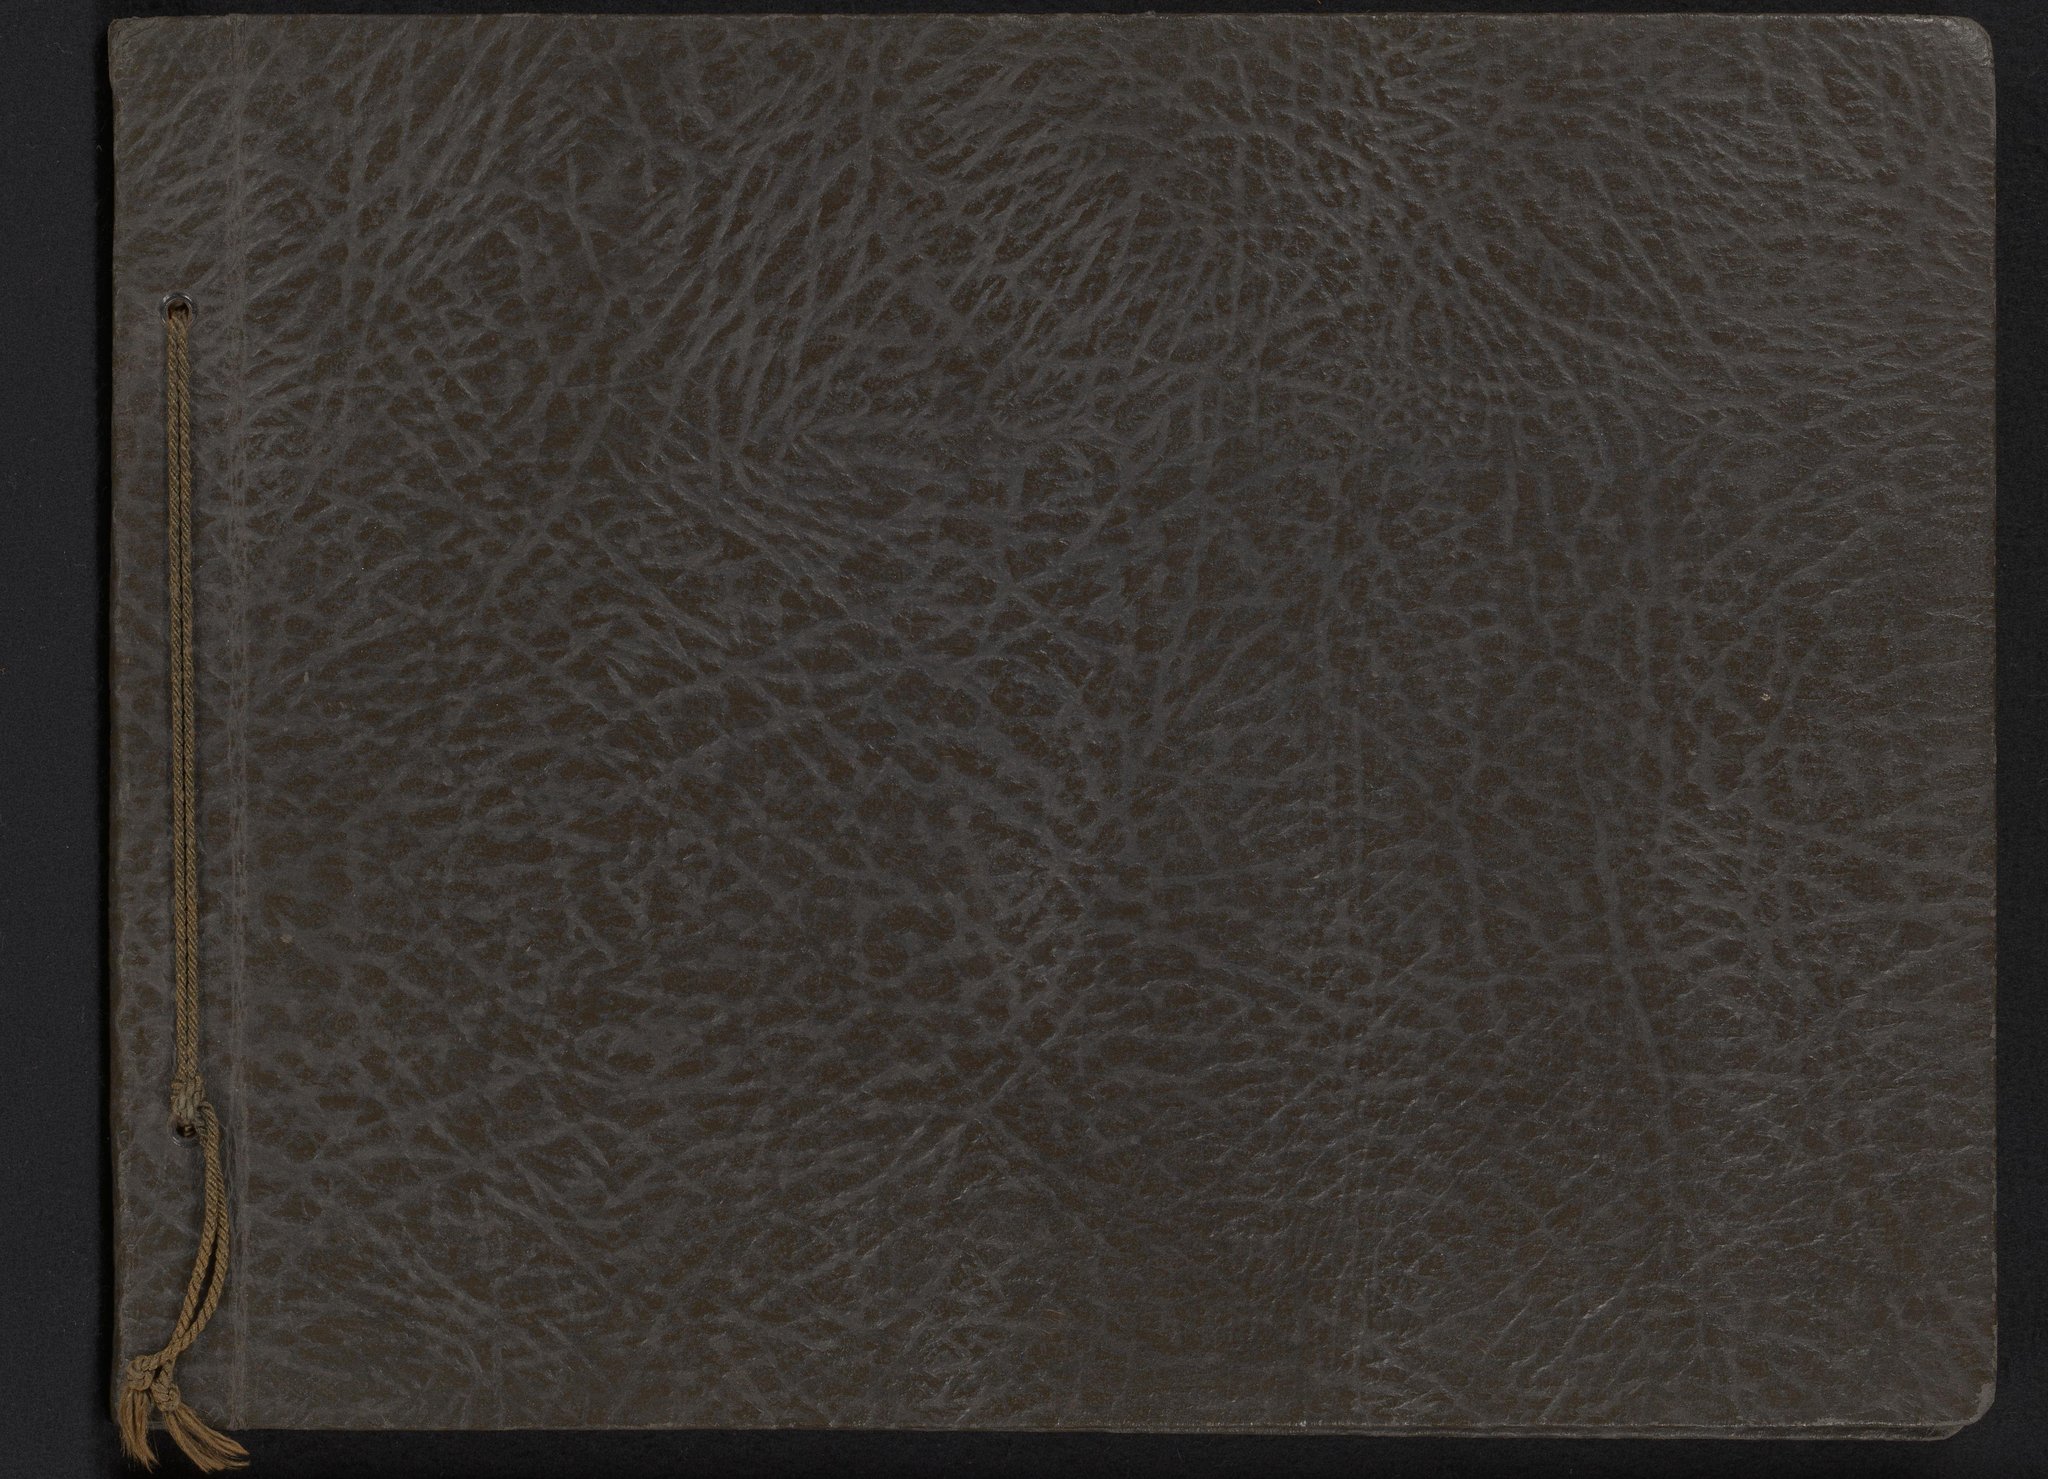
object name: photograph album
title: Fotoalbum met kunstnijverheidsvoorwerpen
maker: Anonymous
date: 1920-1940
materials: cardboard, paper, fiber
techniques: gelatin silver print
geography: netherlands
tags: piece of sculpture, reproduction of a piece of sculpture, coin, lighting; lamps, book-cover, binding, furniture and household effects, sculpture (+ relief ~ sculpture)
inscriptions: retailer's mark: ‘FOTAX/ WAGENSTRAAT 73/ DEN HAAG’, retailer's mark: ‘LeiBag’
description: Fotoalbum met 49 pagina's met in totaal 239 foto's van kunstnijverheidsvoorwerpen, sculpturen en decoraties. De foto's zijn gemaakt door een anonieme fotograaf, vermoedelijk in Nederland.